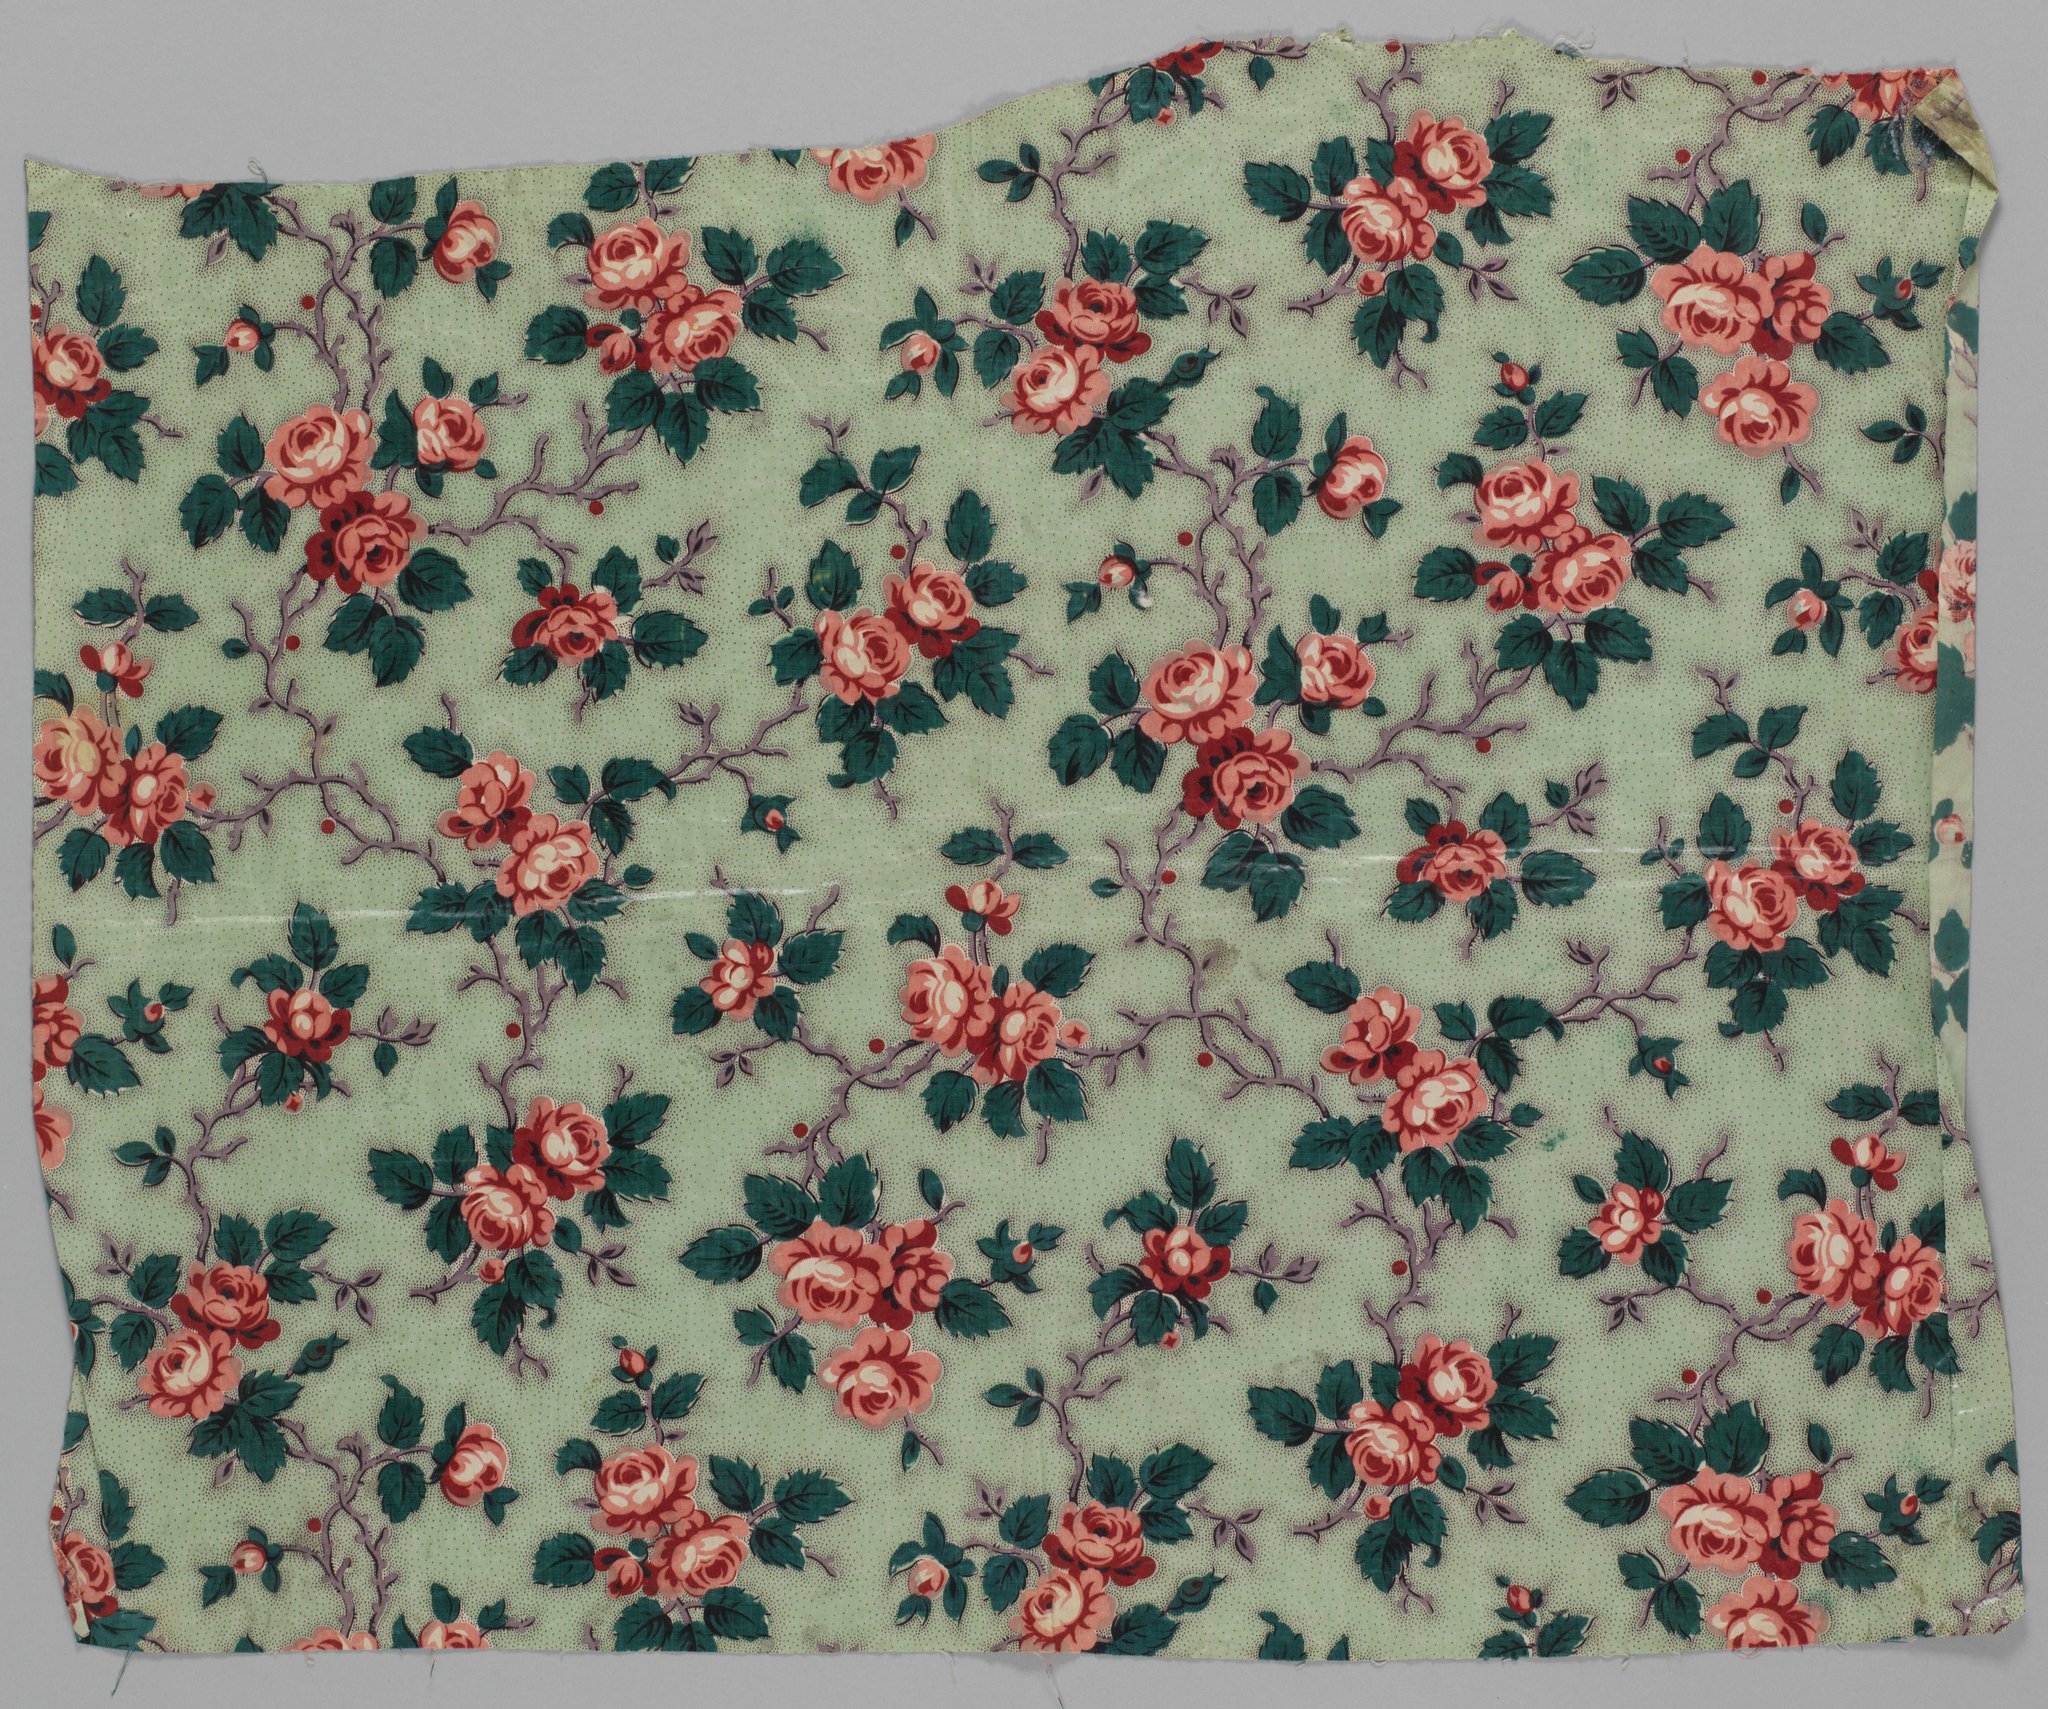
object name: piece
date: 1840-1850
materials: cotton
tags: roses